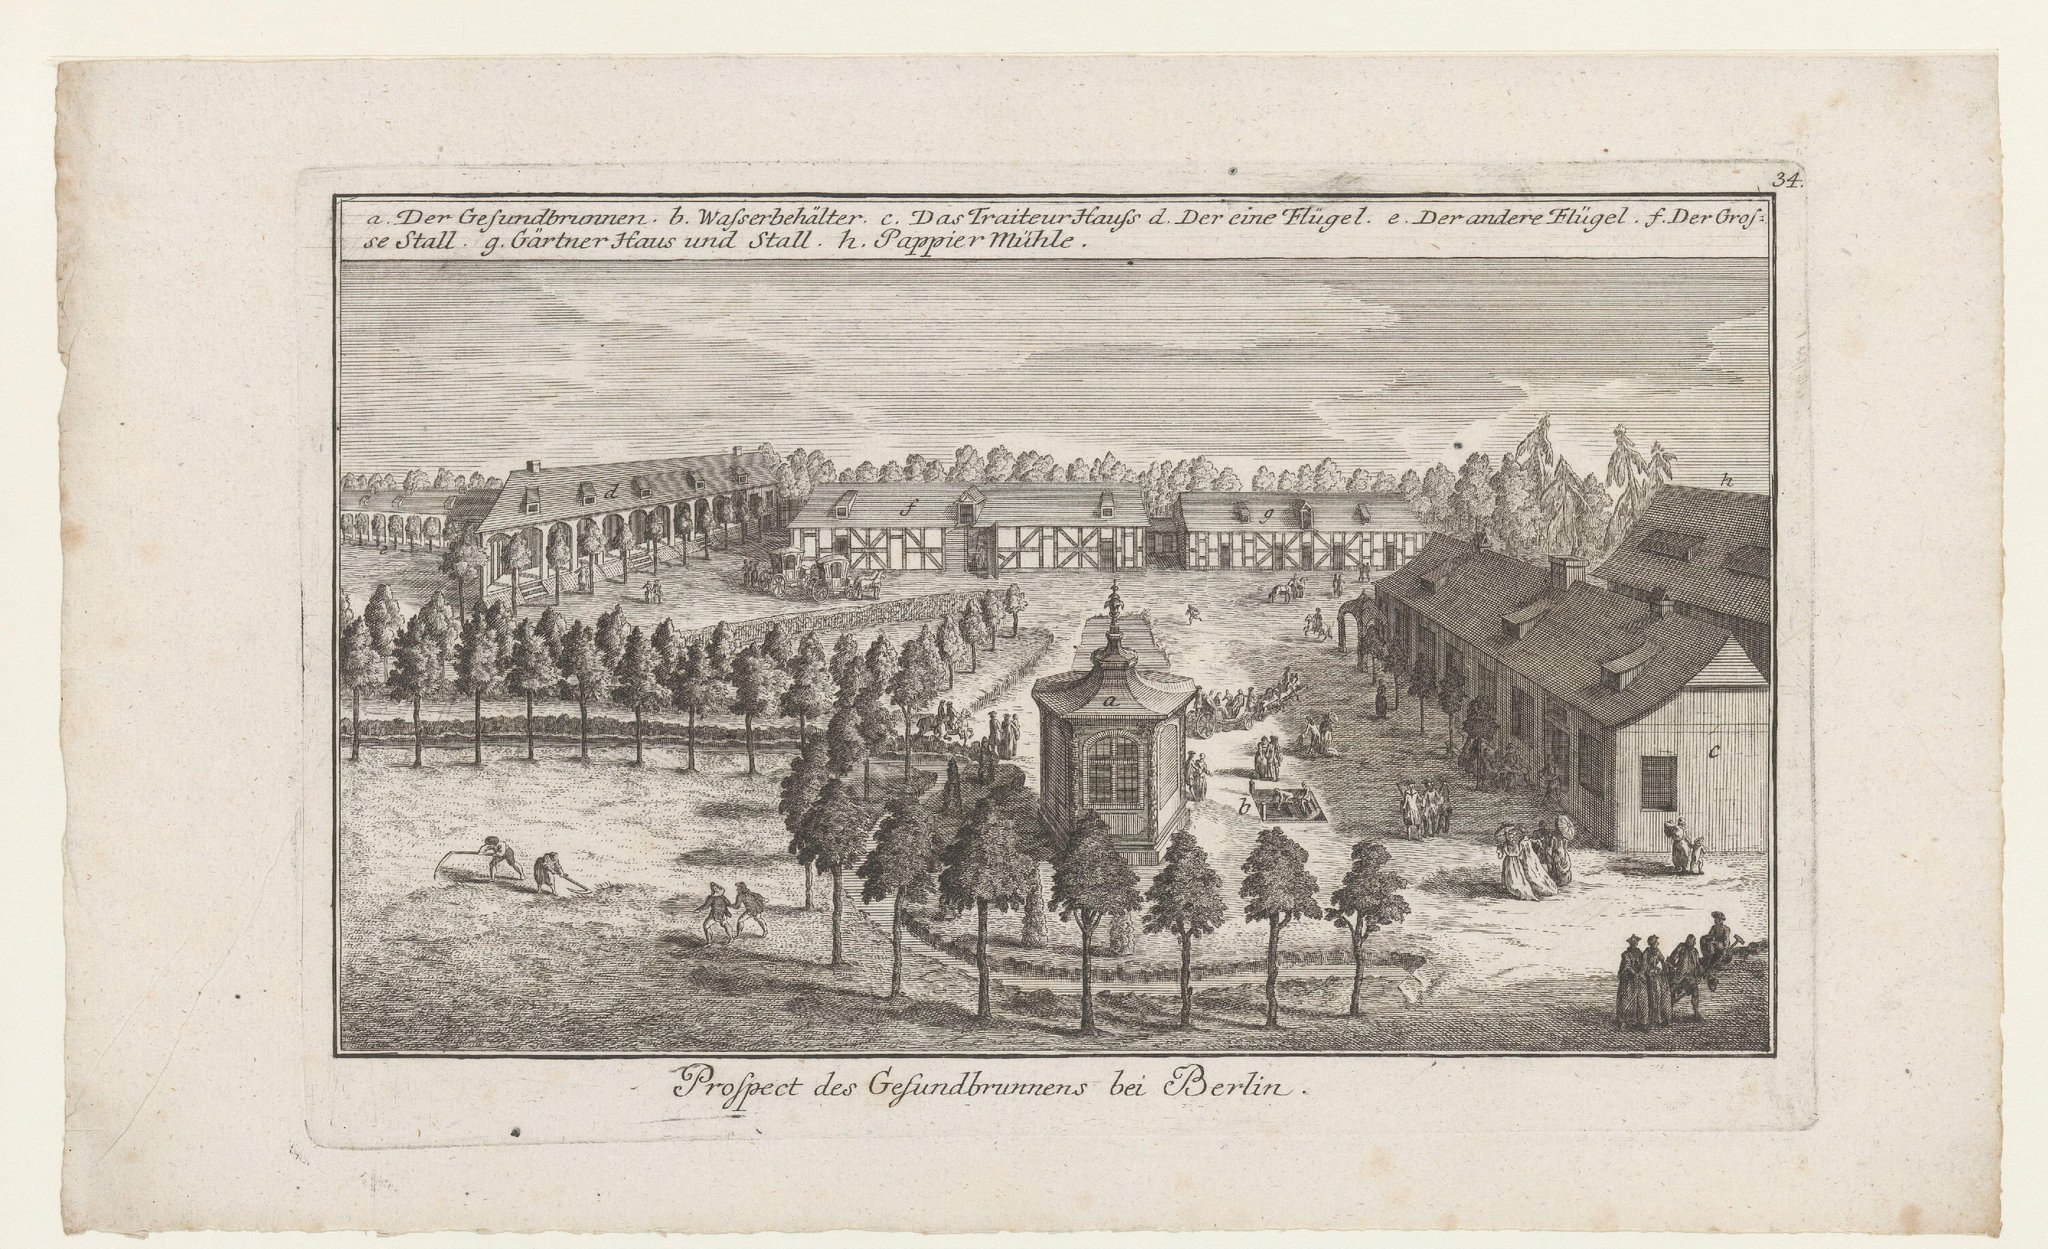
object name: print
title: Gezicht op een waterbron, te Berlijn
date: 1740-1774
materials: paper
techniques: engraving, etching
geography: berlin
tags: mineral water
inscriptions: collector's mark: Lugt 2228